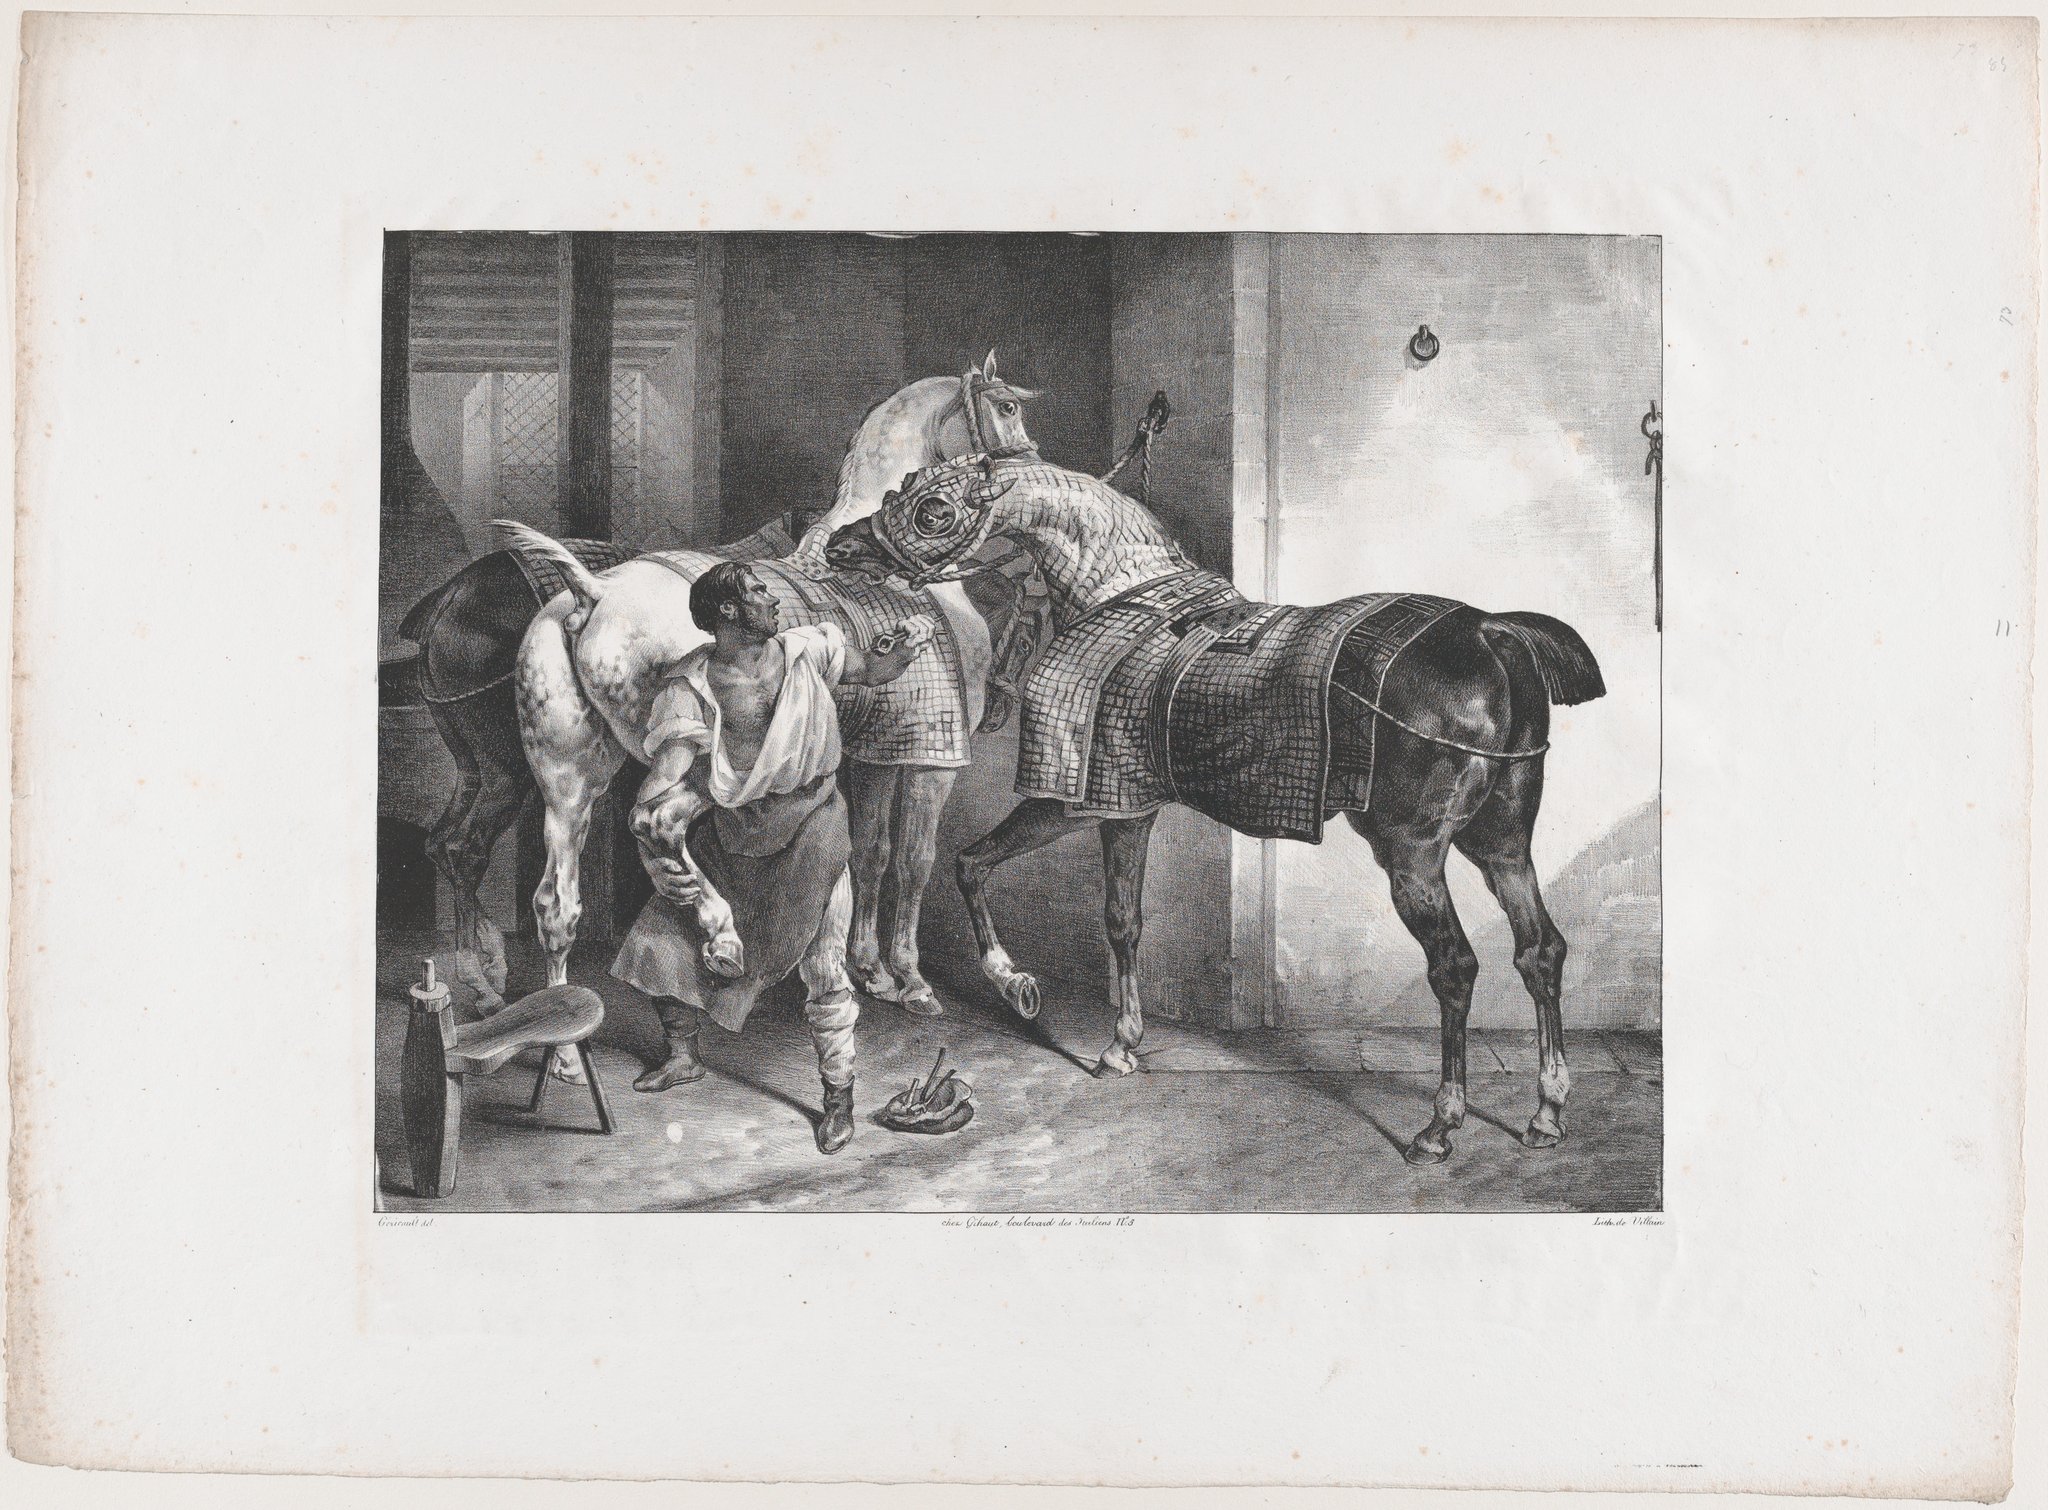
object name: print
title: The English Blacksmith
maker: jean louis andré théodore géricault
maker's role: artist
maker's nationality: french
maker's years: 1791-1824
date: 1822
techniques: lithograph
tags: men,horses,blacksmiths